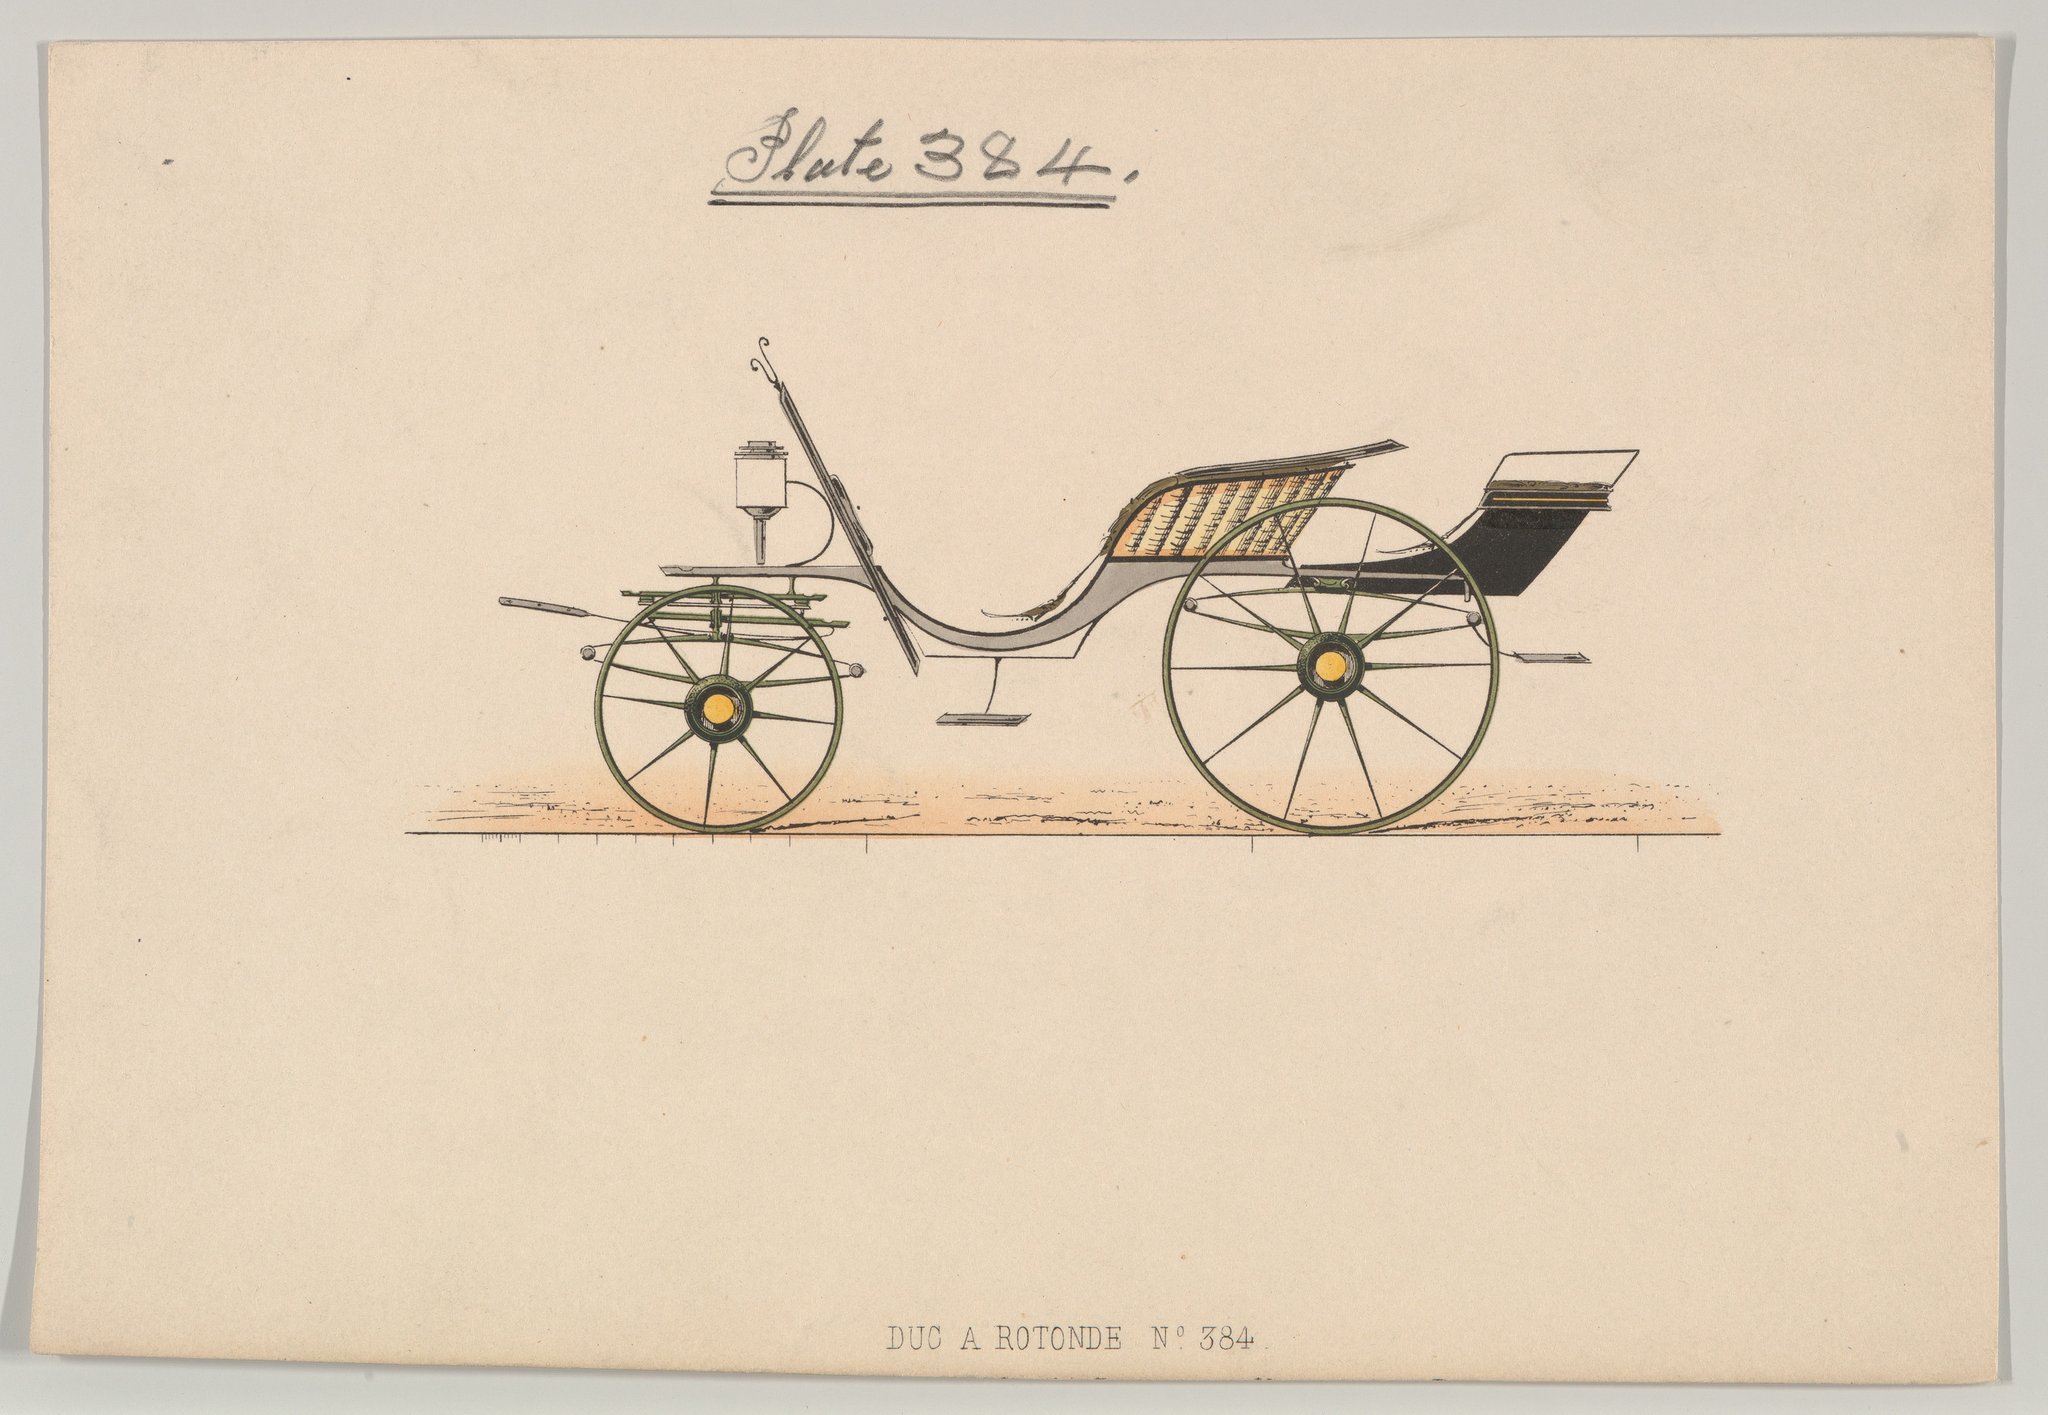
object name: drawing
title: Phaeton or "Duc a Rotonde Plate 384"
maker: brewster & co.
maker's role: manufacturer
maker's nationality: american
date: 1860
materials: graphite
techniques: printing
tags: carriages